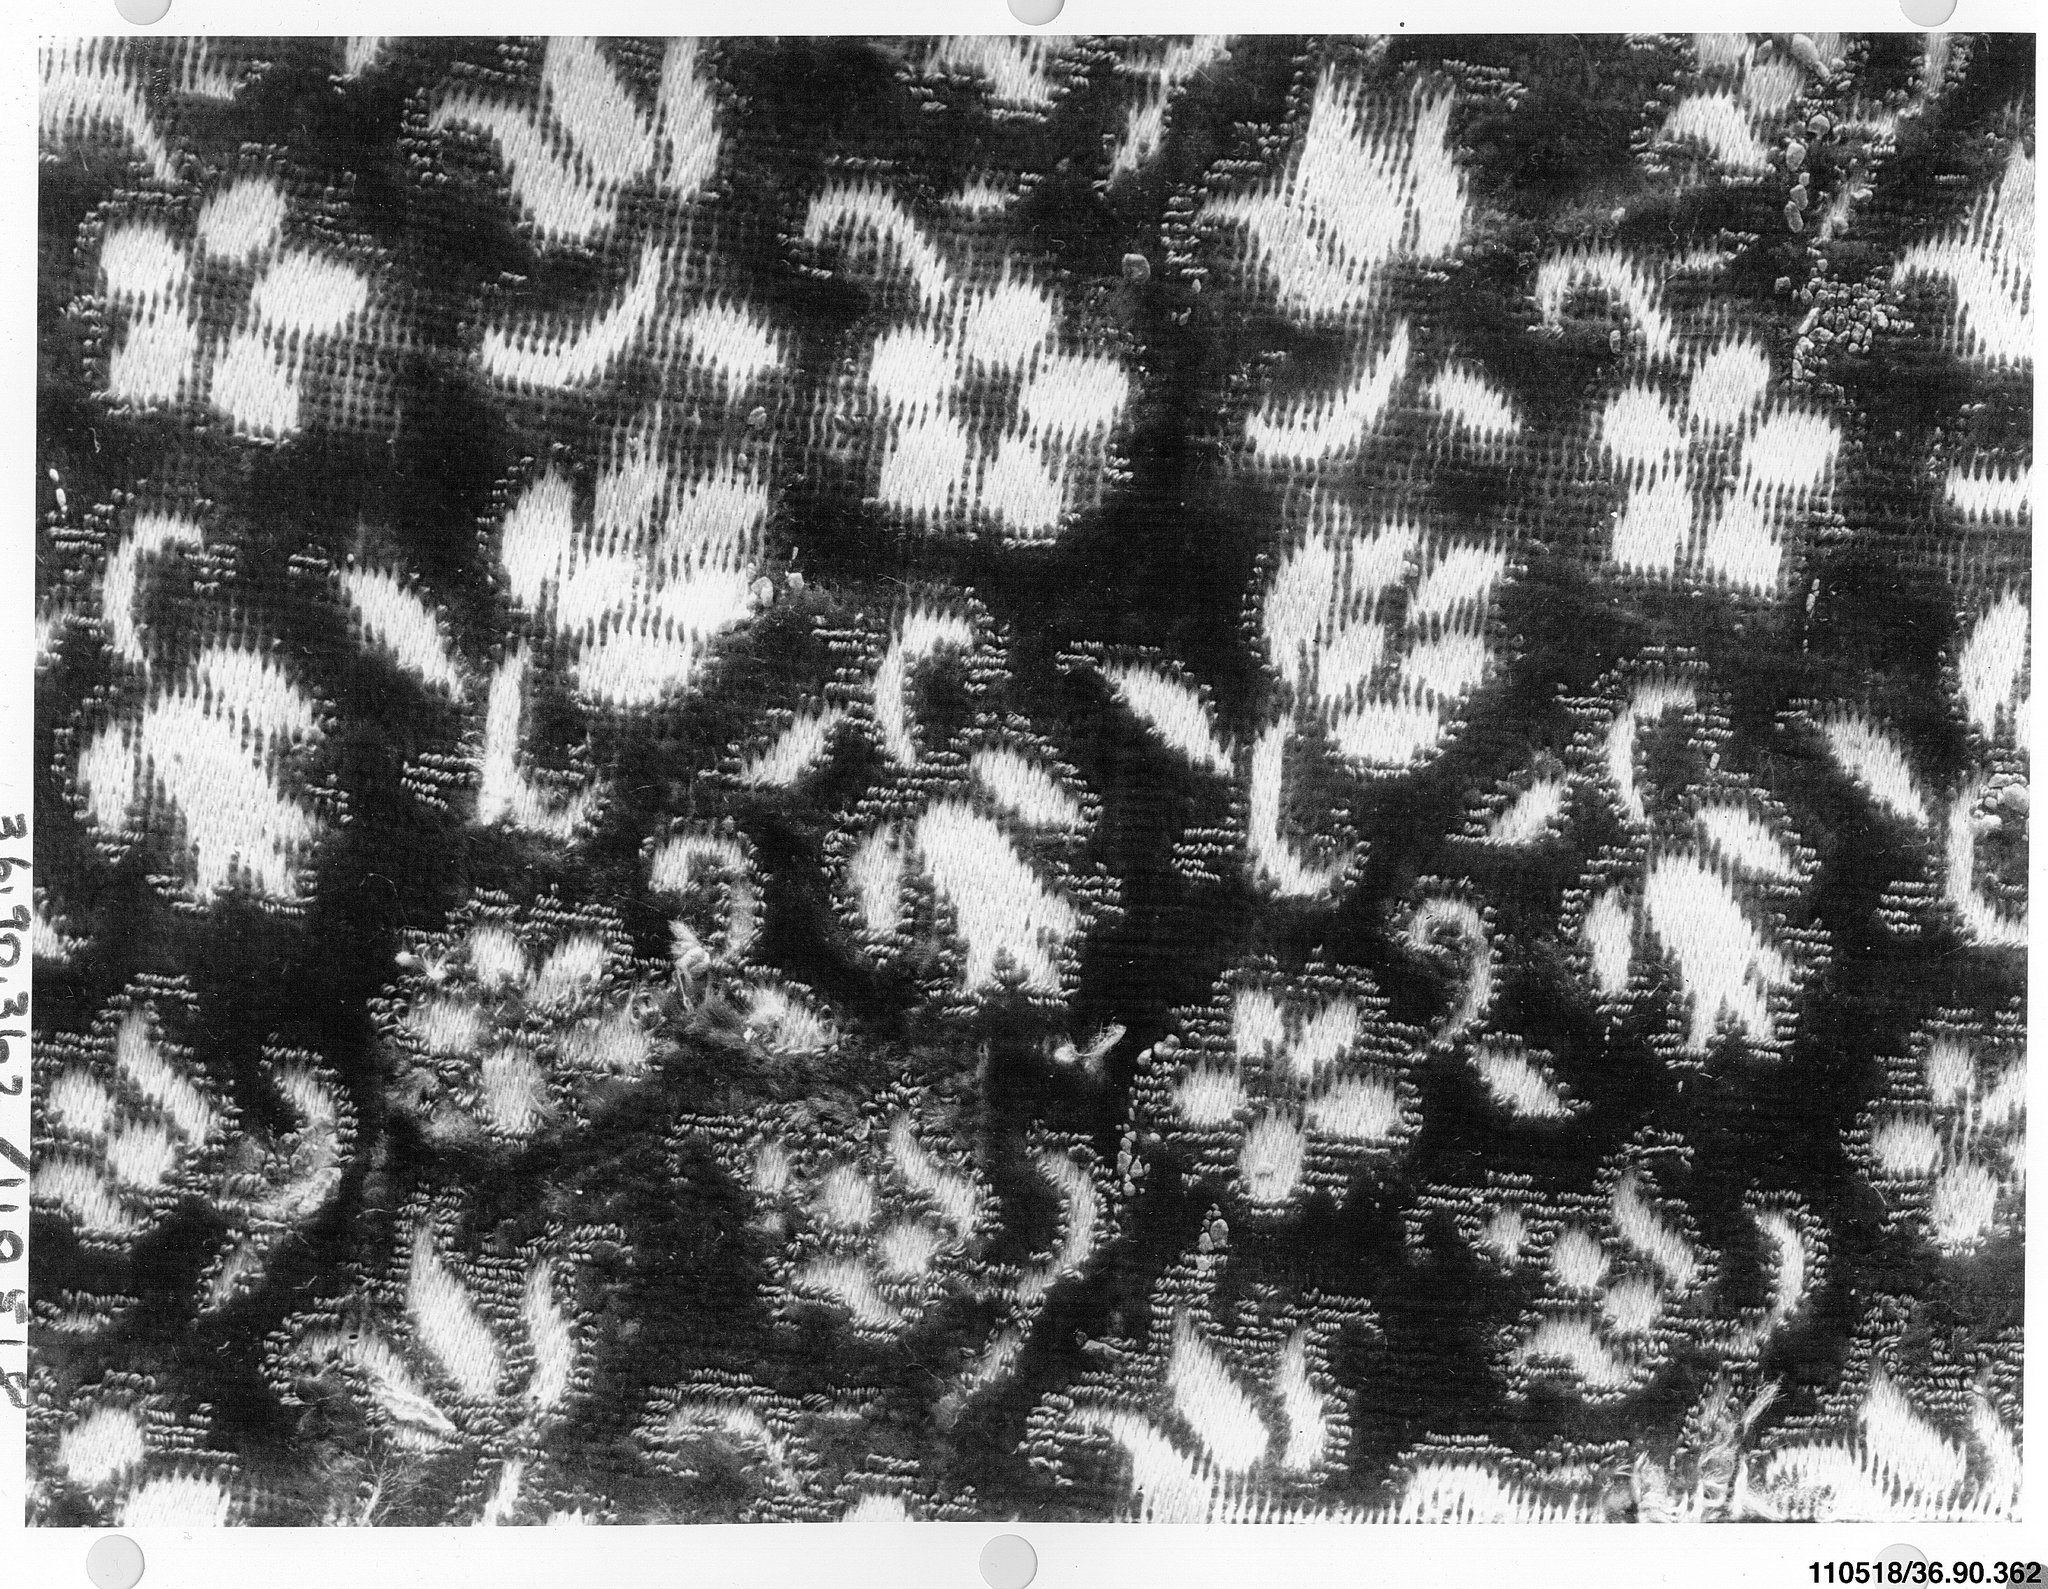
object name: piece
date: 1501-1700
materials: silk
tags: flowers